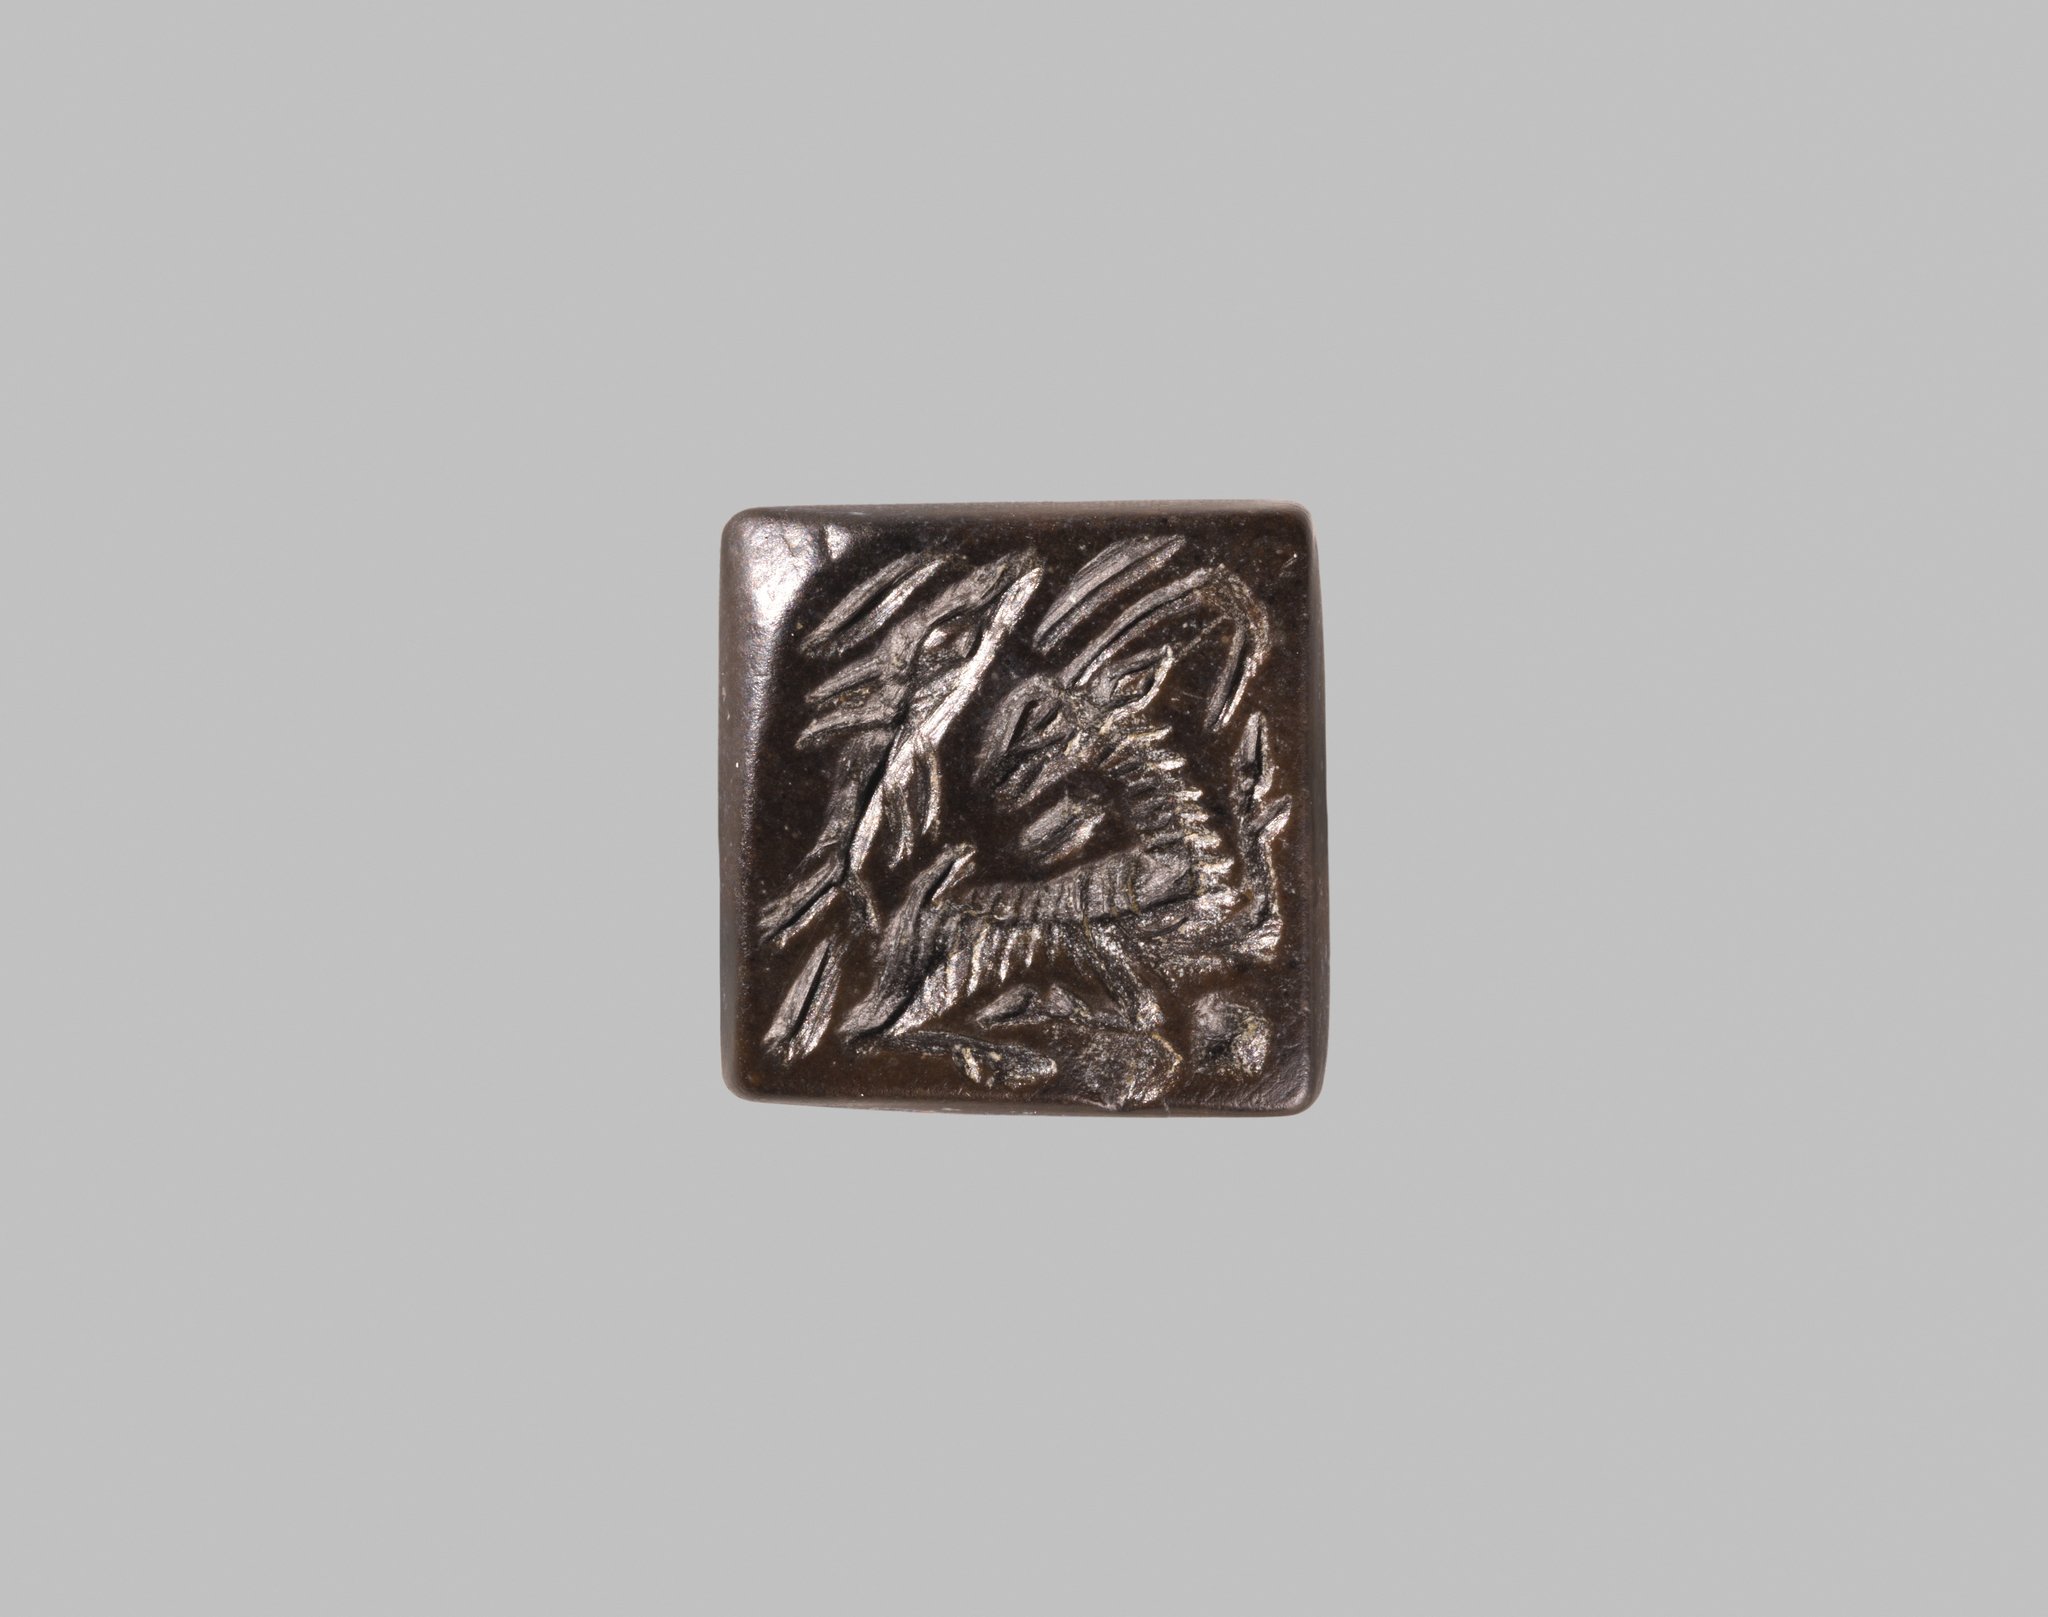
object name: stamp seal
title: Square plaque seal with stalk handle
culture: assyrian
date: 2000-1668 BCE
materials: mineral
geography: anatolia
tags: goats